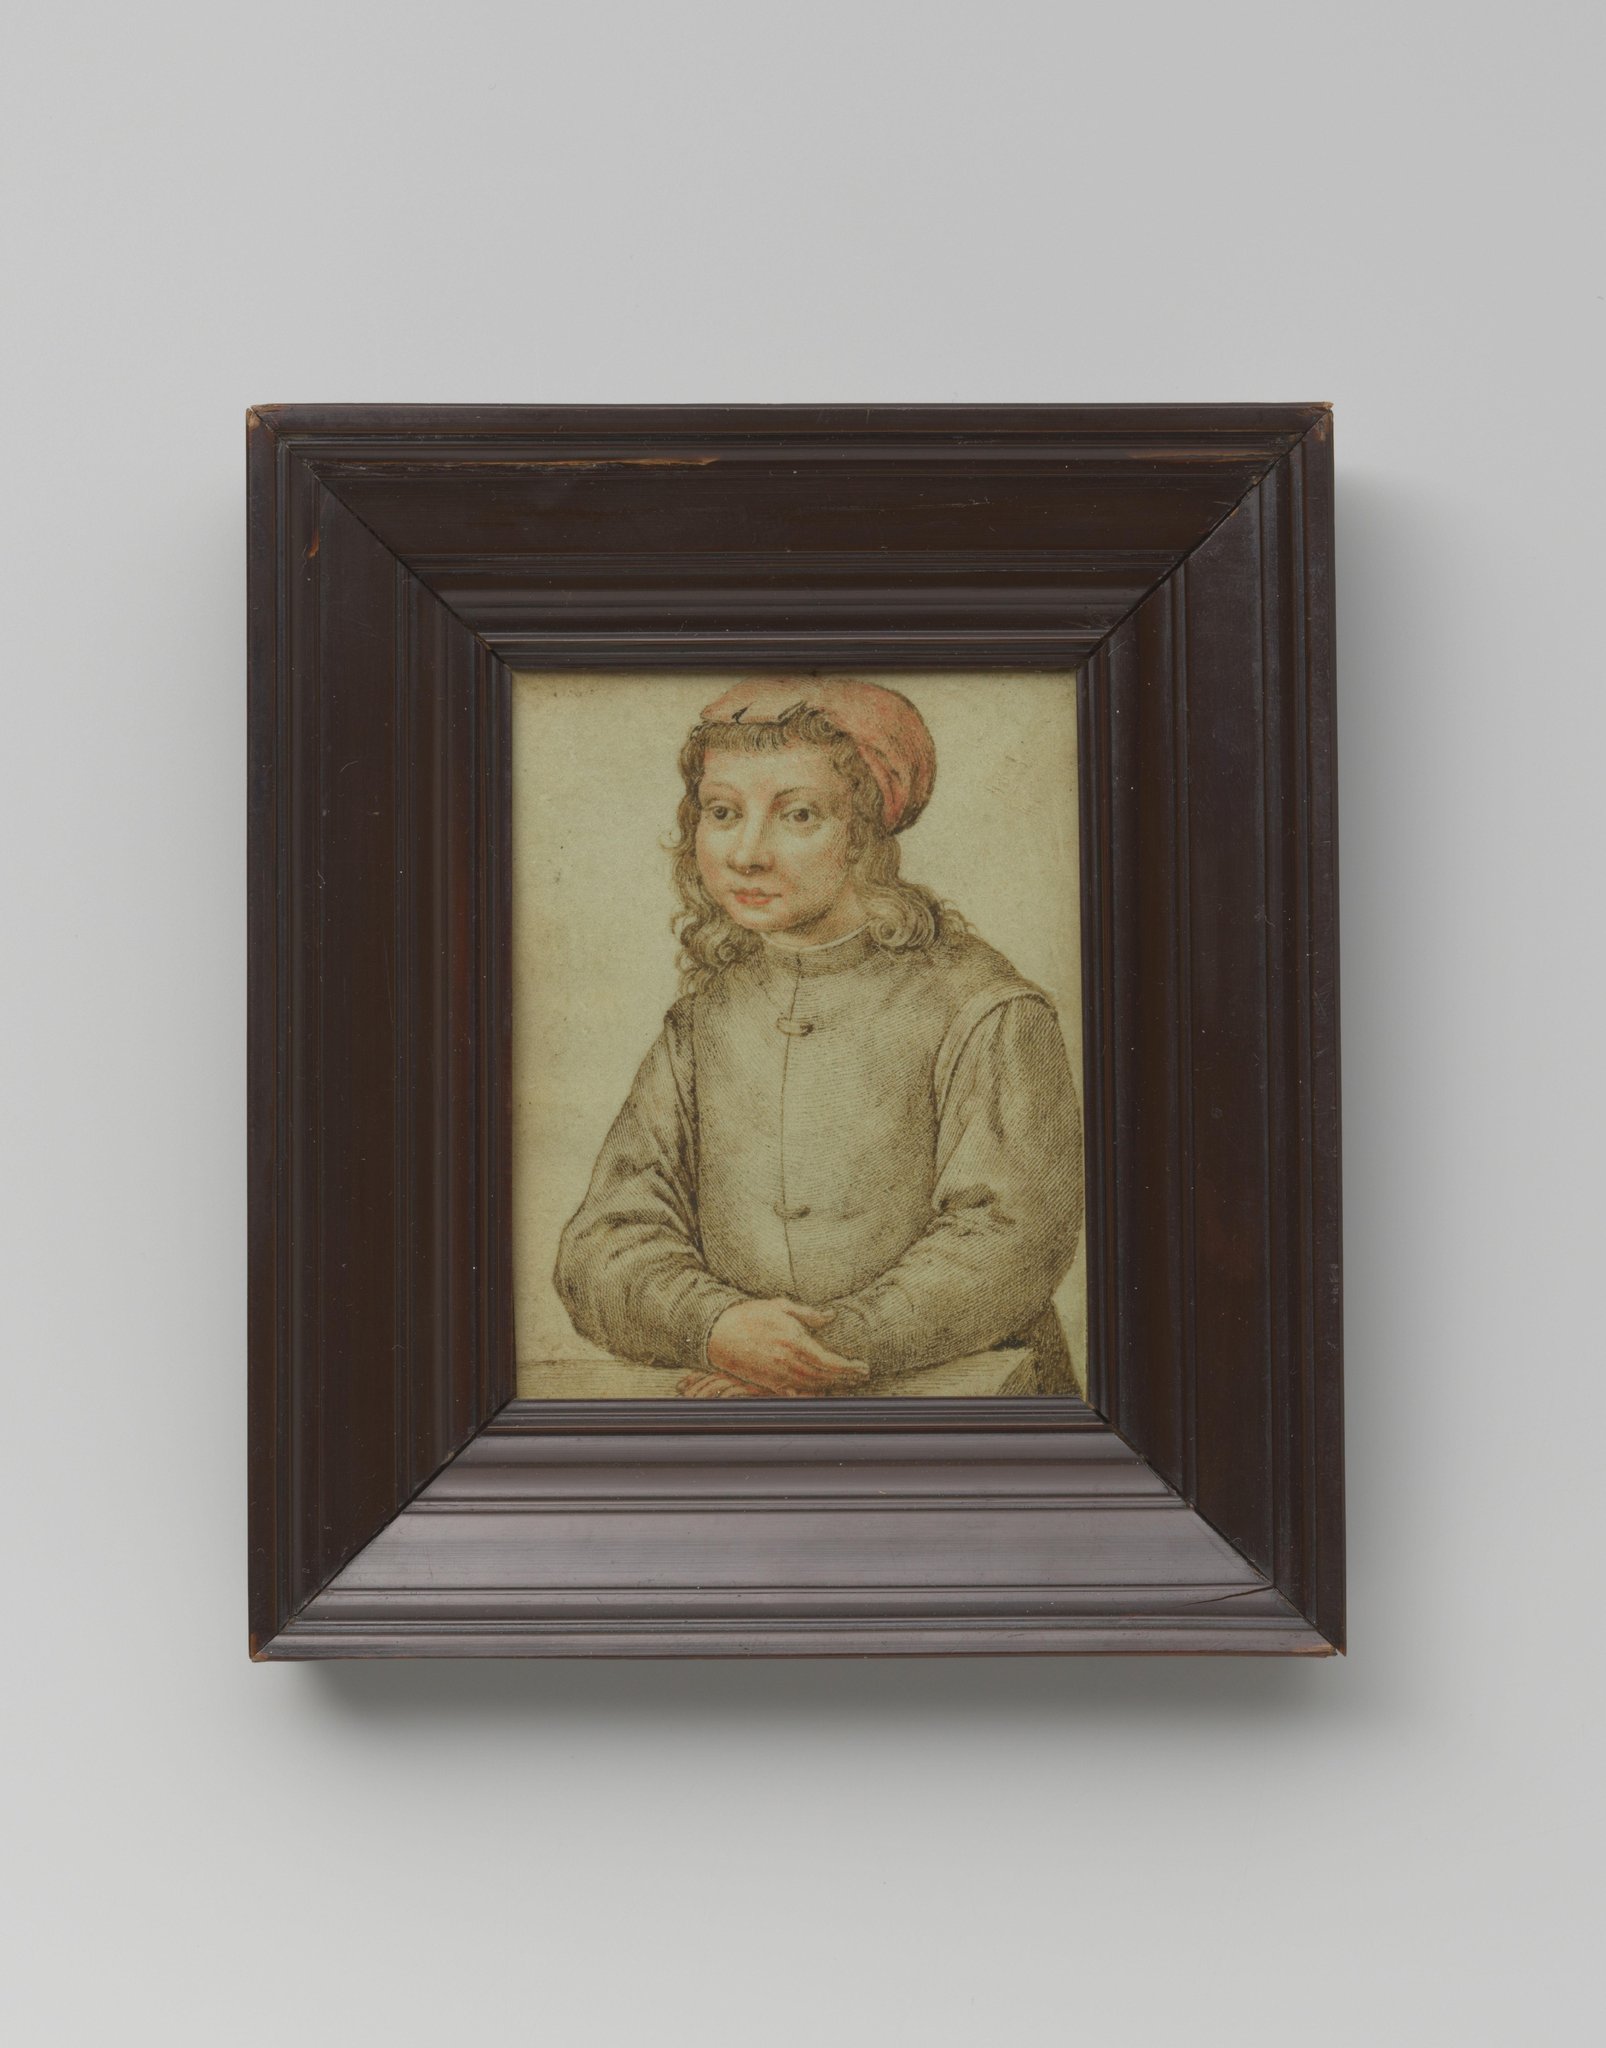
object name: miniature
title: Tekening, portret van een onbekend jongetje in 16de-eeuws kostuum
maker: Anonymous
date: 1600-1650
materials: baleen, glass, ink, wood, parchment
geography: netherlands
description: Tekening, portret van een onbekend jongetje in 16de-eeuws kostuum, gewassen pentekening in bruin en rood op perkament, achter glas gevat in een geprofileerde lijst van walvisbalein op eikenhout.